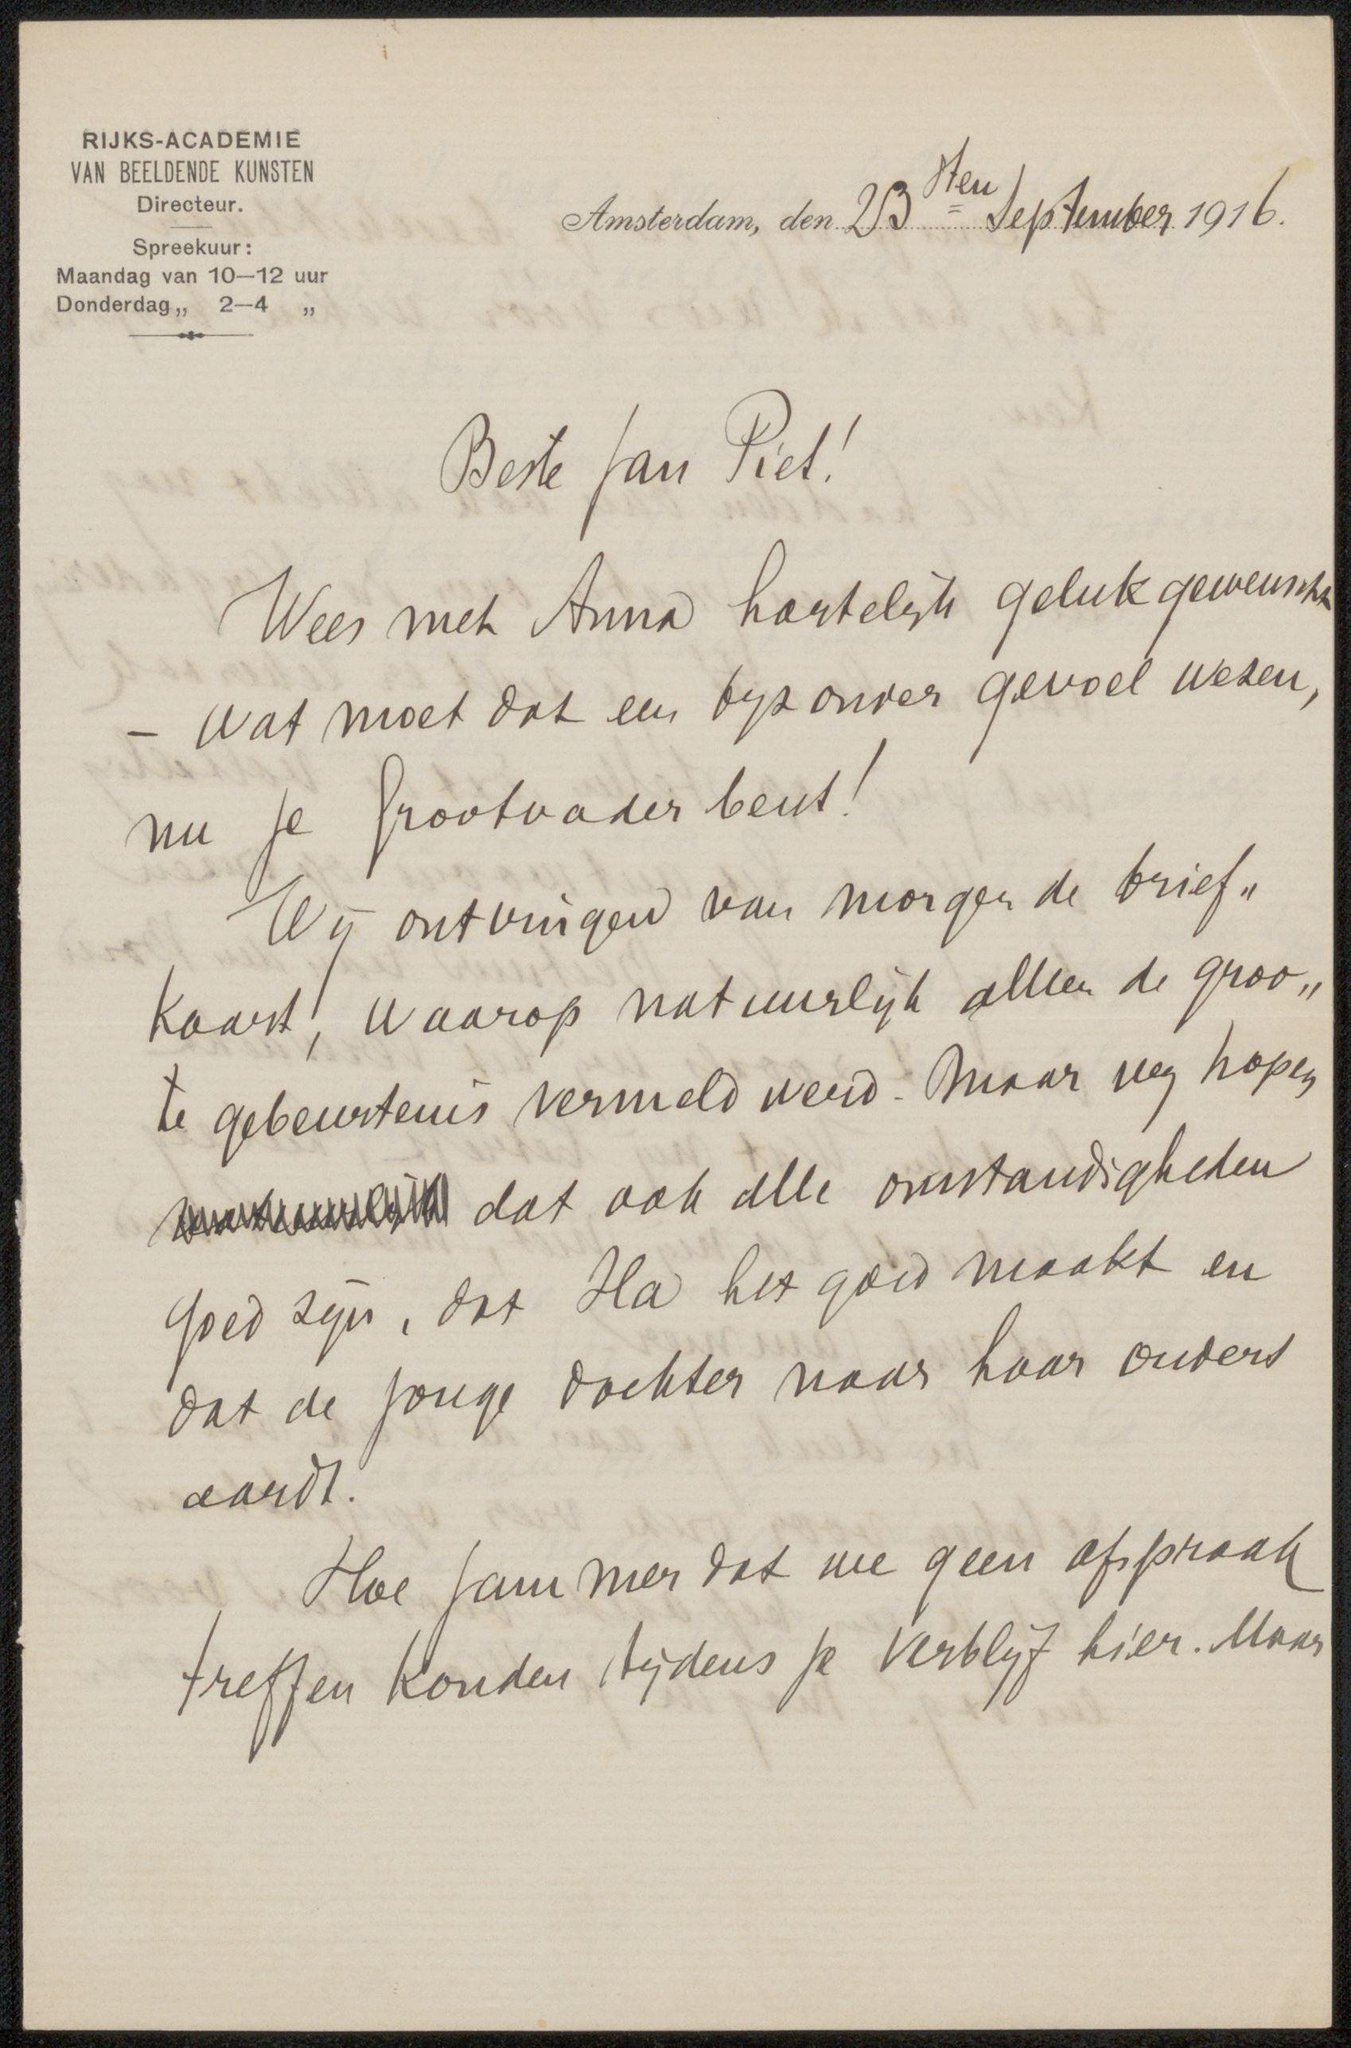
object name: letter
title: Brief aan Jan Veth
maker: antoon derkinderen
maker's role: draughtsman, painter, print maker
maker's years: 1859-1925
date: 1916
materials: ink, paper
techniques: pen, printing, writing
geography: amsterdam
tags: amsterdam, print maker, draughtsman, august allebé, dordrecht, painter, designer, jan veth, art trade, art shop, family life, painting (including book-illumination, miniature-painting)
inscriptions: collector's mark: ‘RPK’